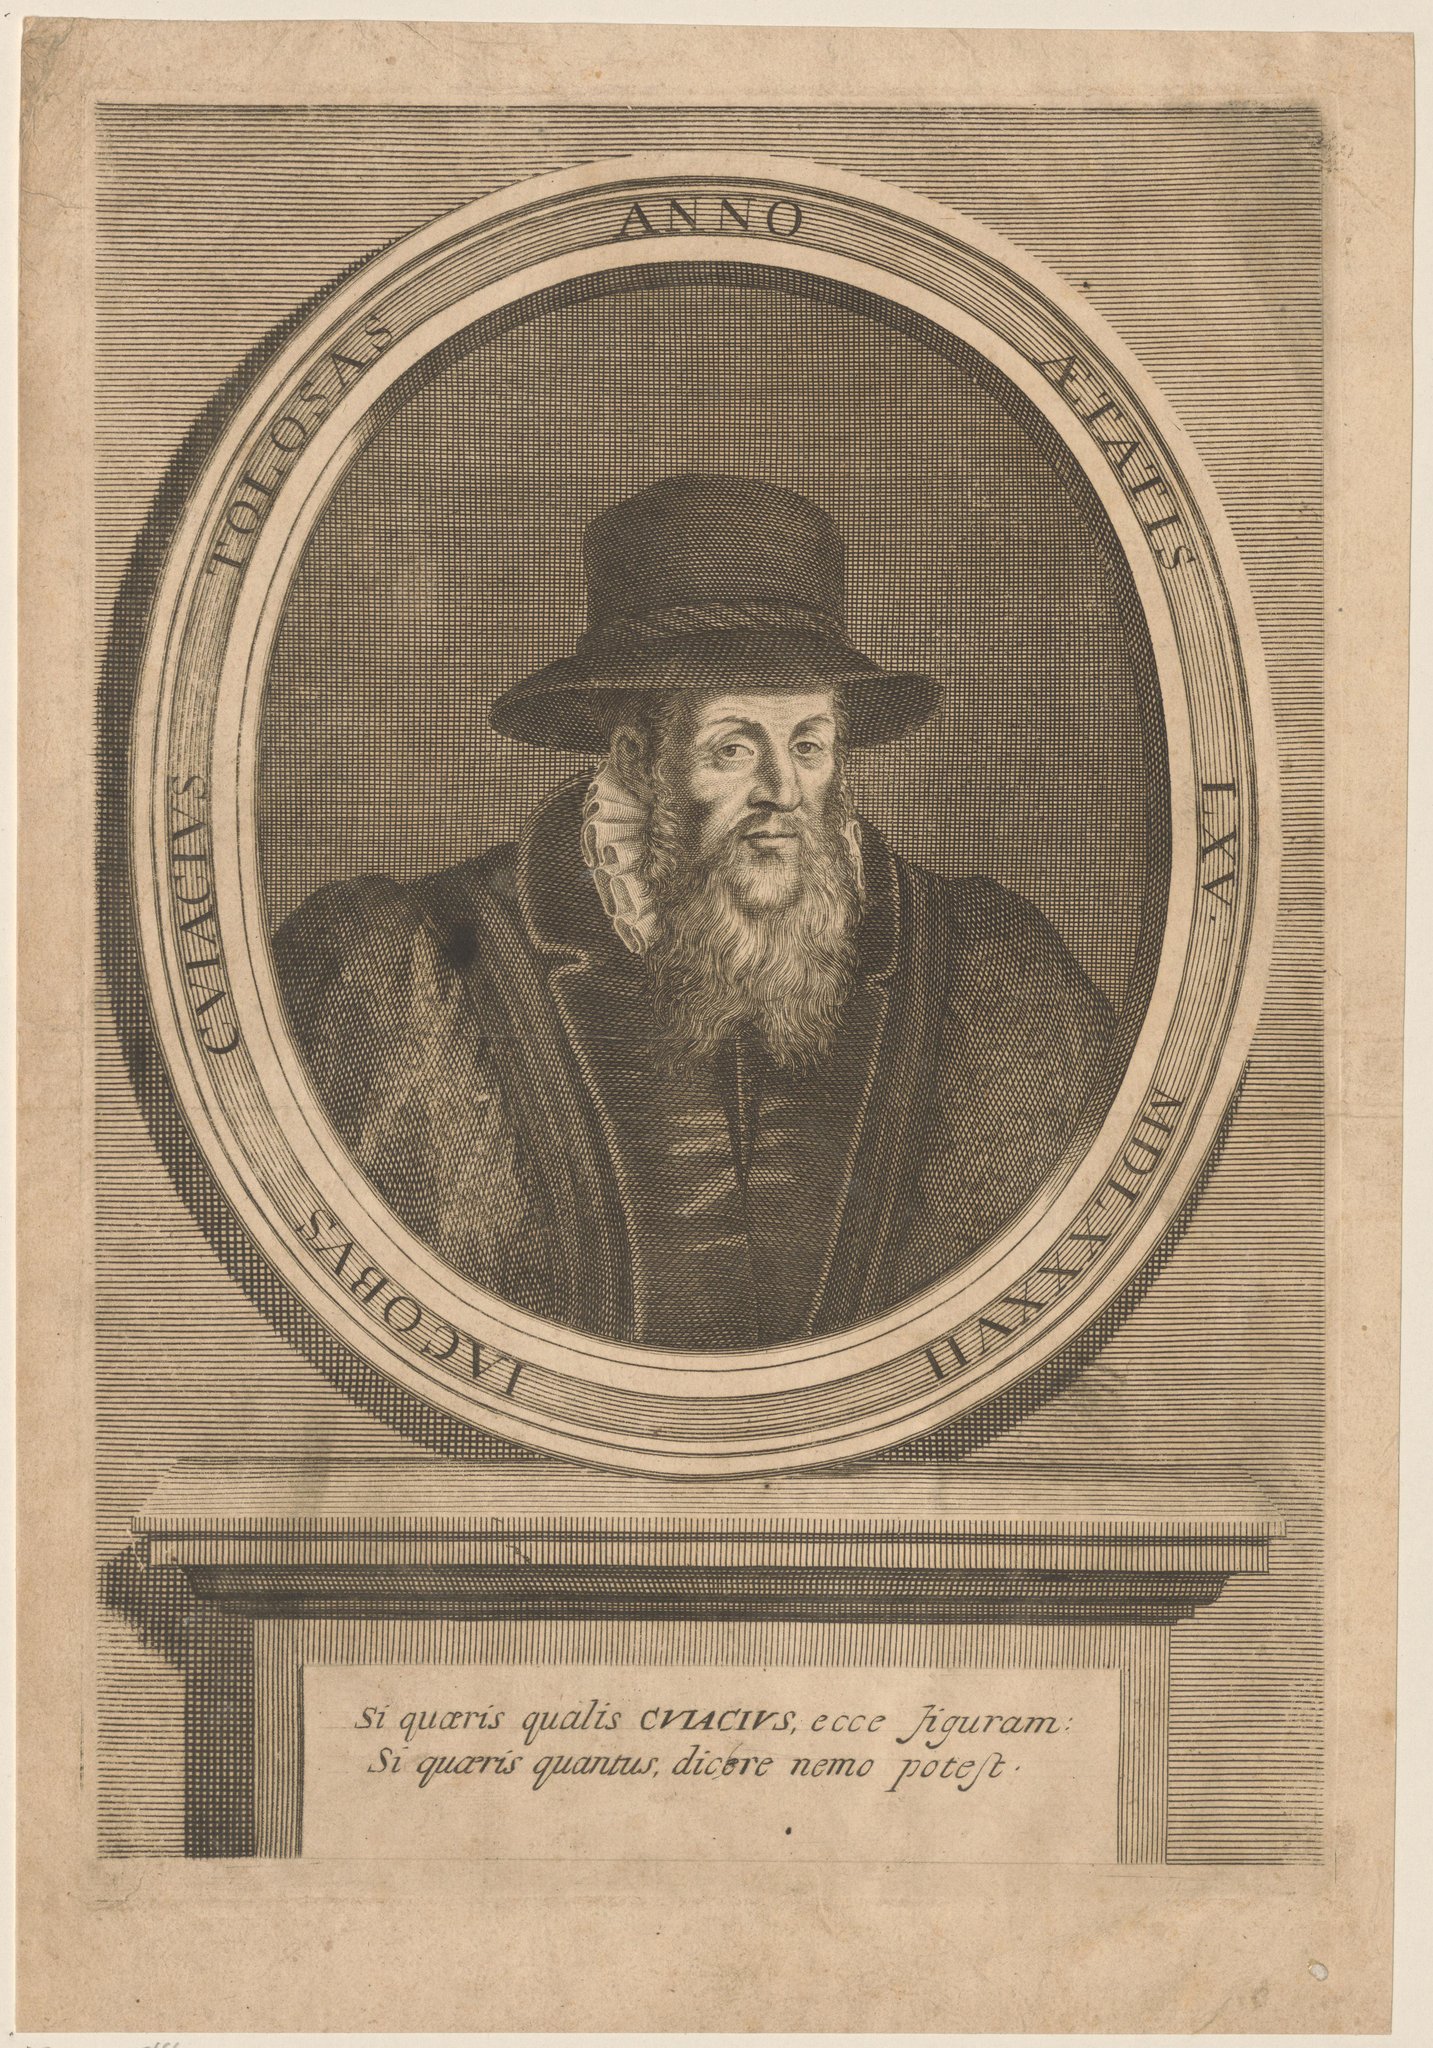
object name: print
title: Portret van Jacques Cujas op 65-jarige leeftijd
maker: Anonymous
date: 1658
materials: paper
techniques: engraving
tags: historical persons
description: Prent mogelijk uit: Cujas, Jacques. Opera Omnia. Napels: s.n., 1658.